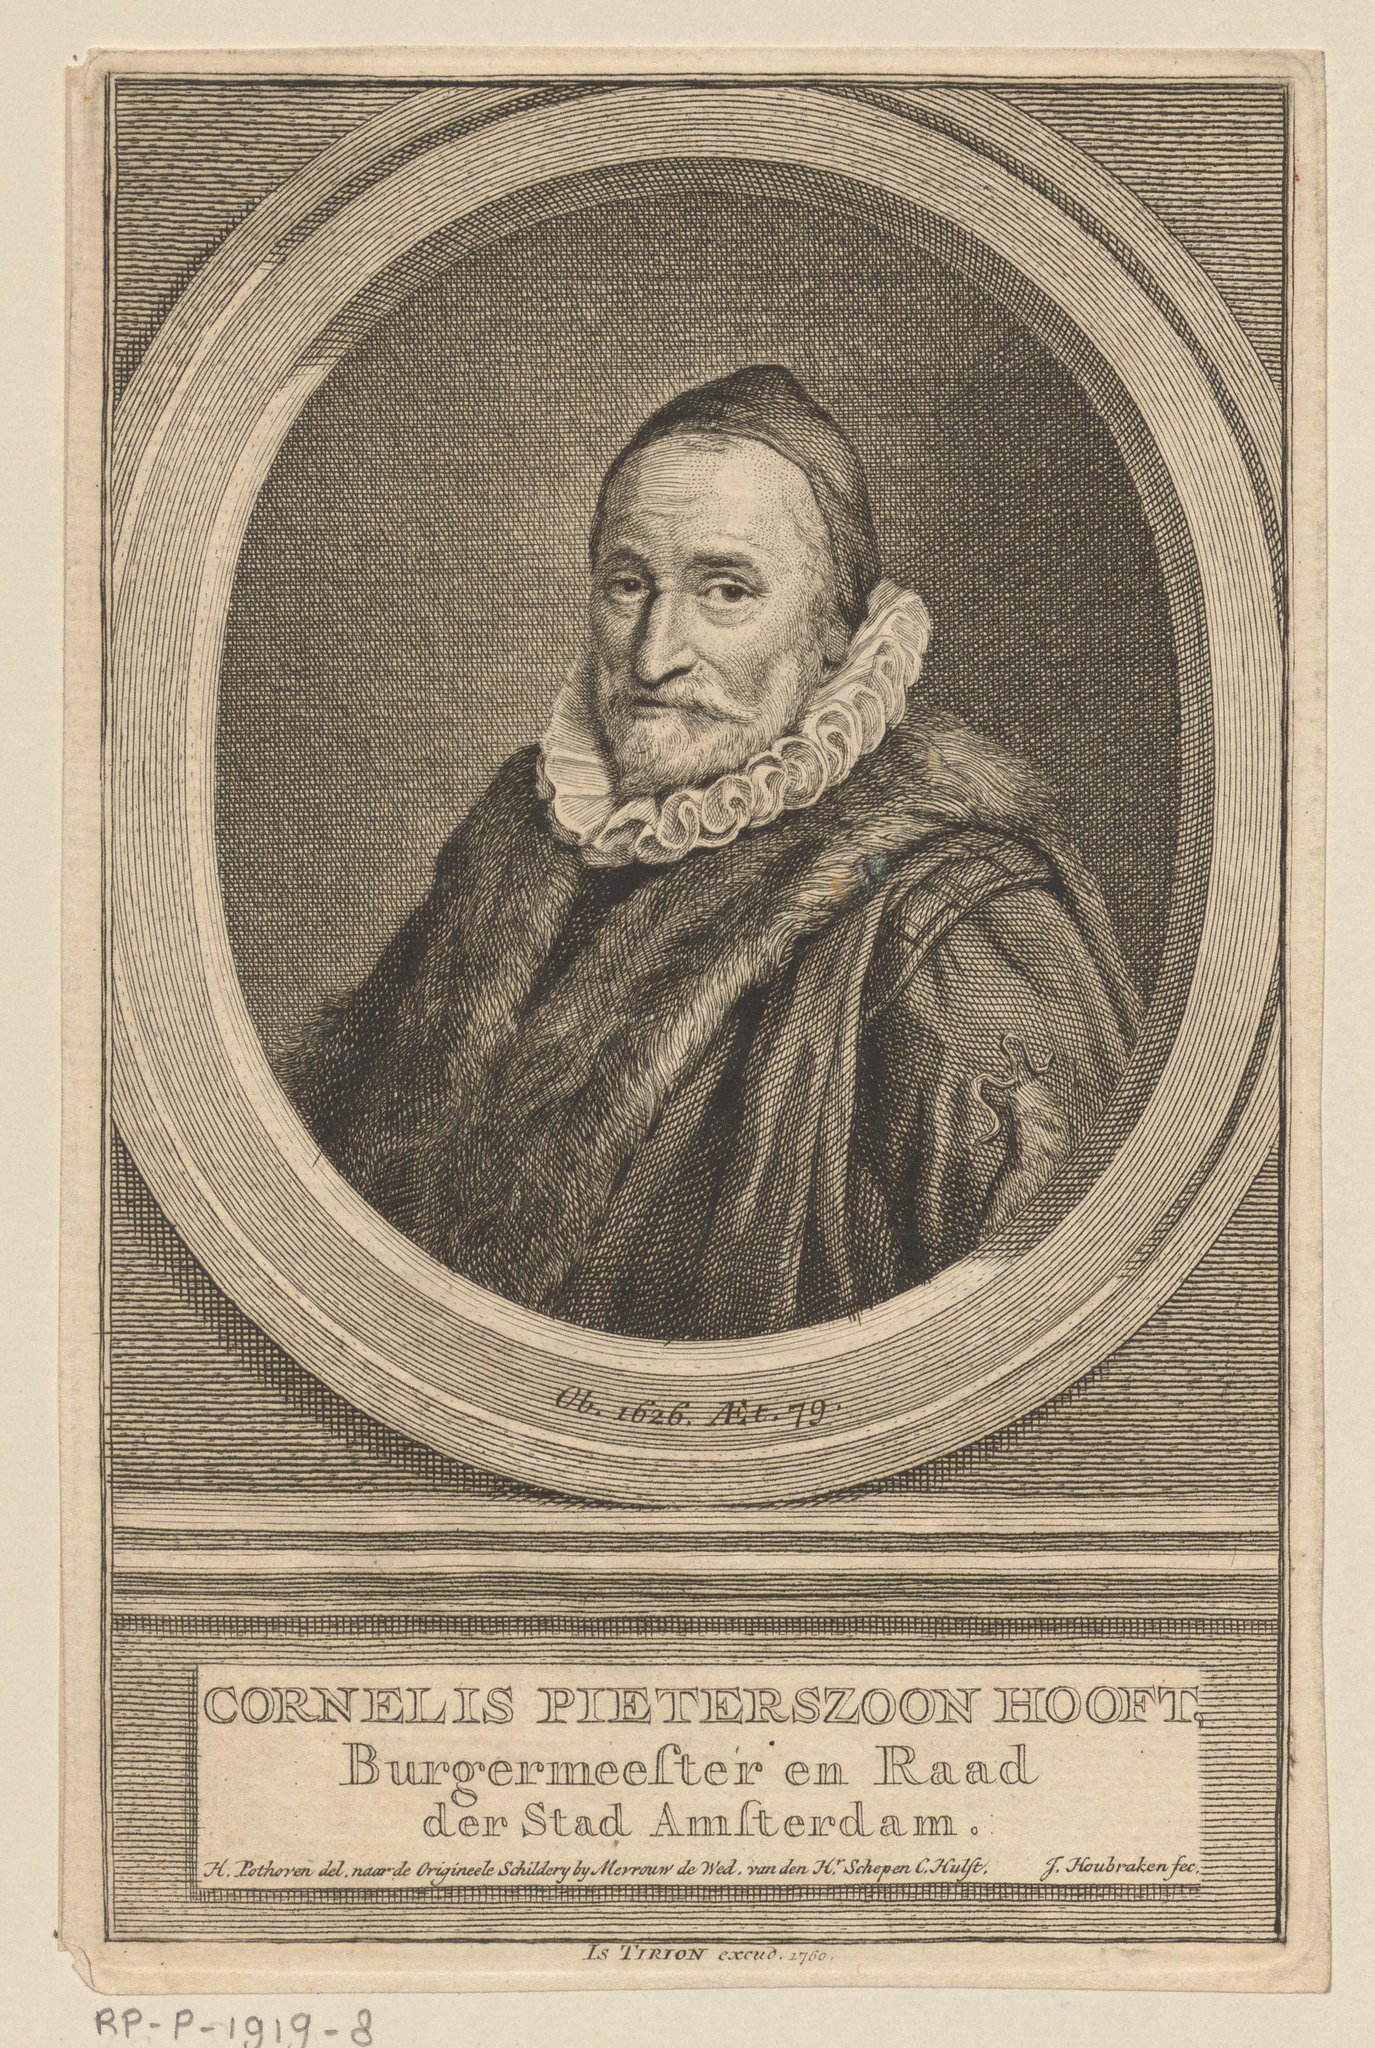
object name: print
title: Portret van Cornelis Pietersz. Hooft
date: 1760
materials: paper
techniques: engraving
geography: amsterdam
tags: amsterdam, mayor, cornelis pietersz. hooft, mayor, burgomaster, historical persons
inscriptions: collector's mark: Lugt 2228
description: Prent ook gebruikt in: Portraiten van vermaarde persoonadien, dienende tot een aanhangsel op de Vaderlandsche historie. Amsterdam: Isaak Tirion, 1761.